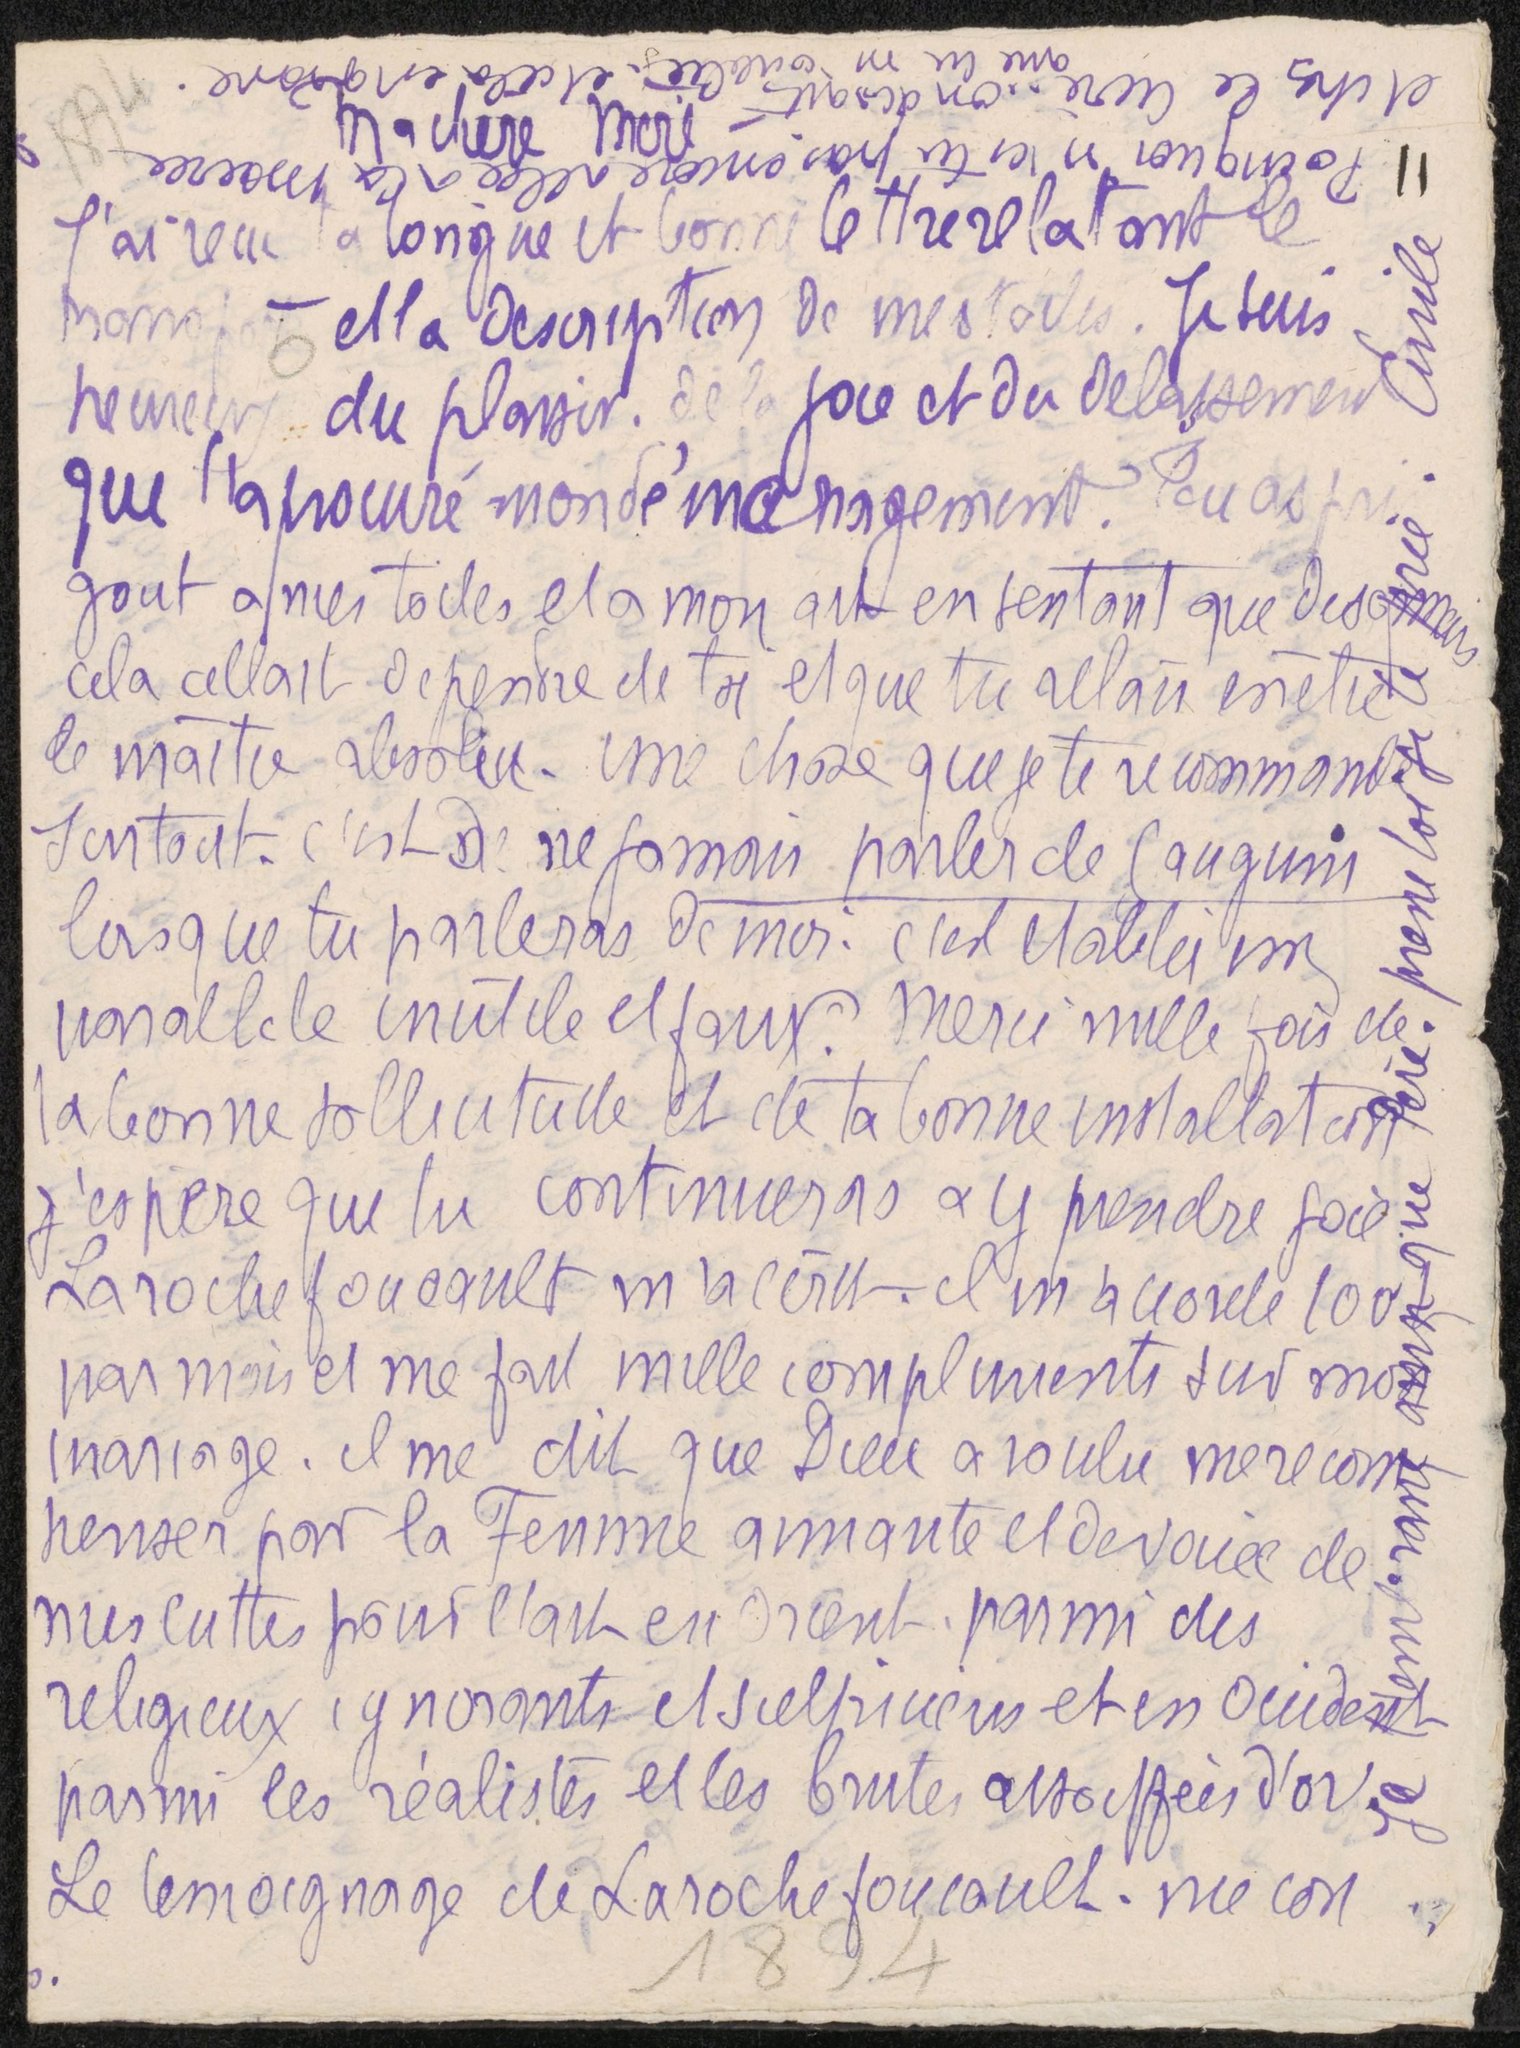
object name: letter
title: Brief aan Héloïse Bernard-Bodin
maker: émile bernard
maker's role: print maker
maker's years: 1868-1941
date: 1878-1941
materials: ink, paper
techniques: pen, writing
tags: héloïse bernard-bodin